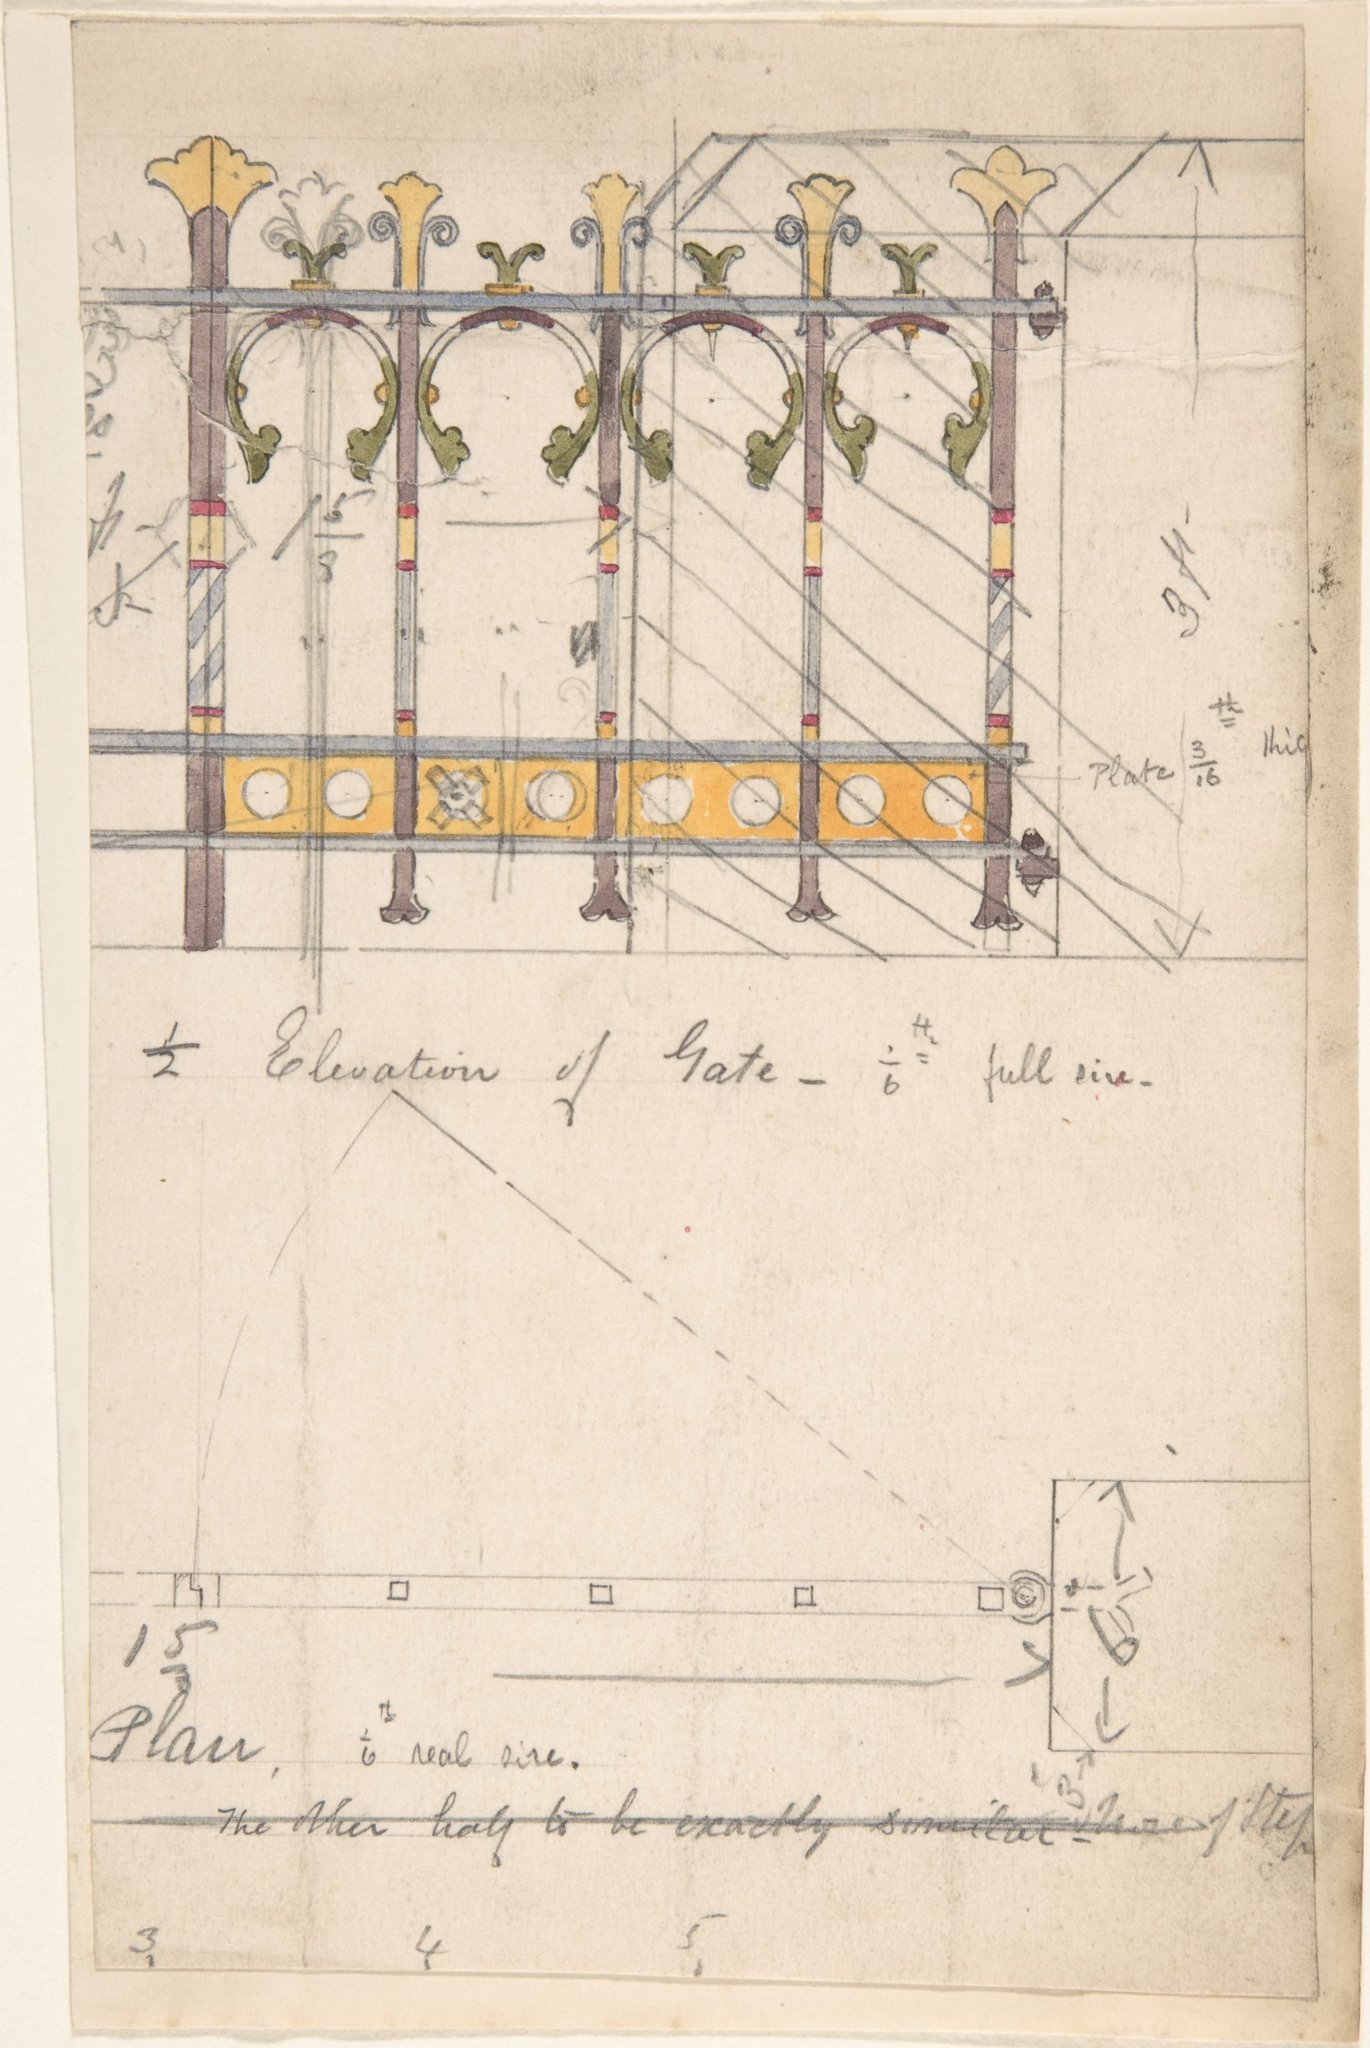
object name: drawing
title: Design for an Iron Gate, Elevation and Plan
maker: richardson ellson & co.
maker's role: artist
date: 1880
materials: ink, watercolor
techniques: brush, pen, wash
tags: architecture,gates